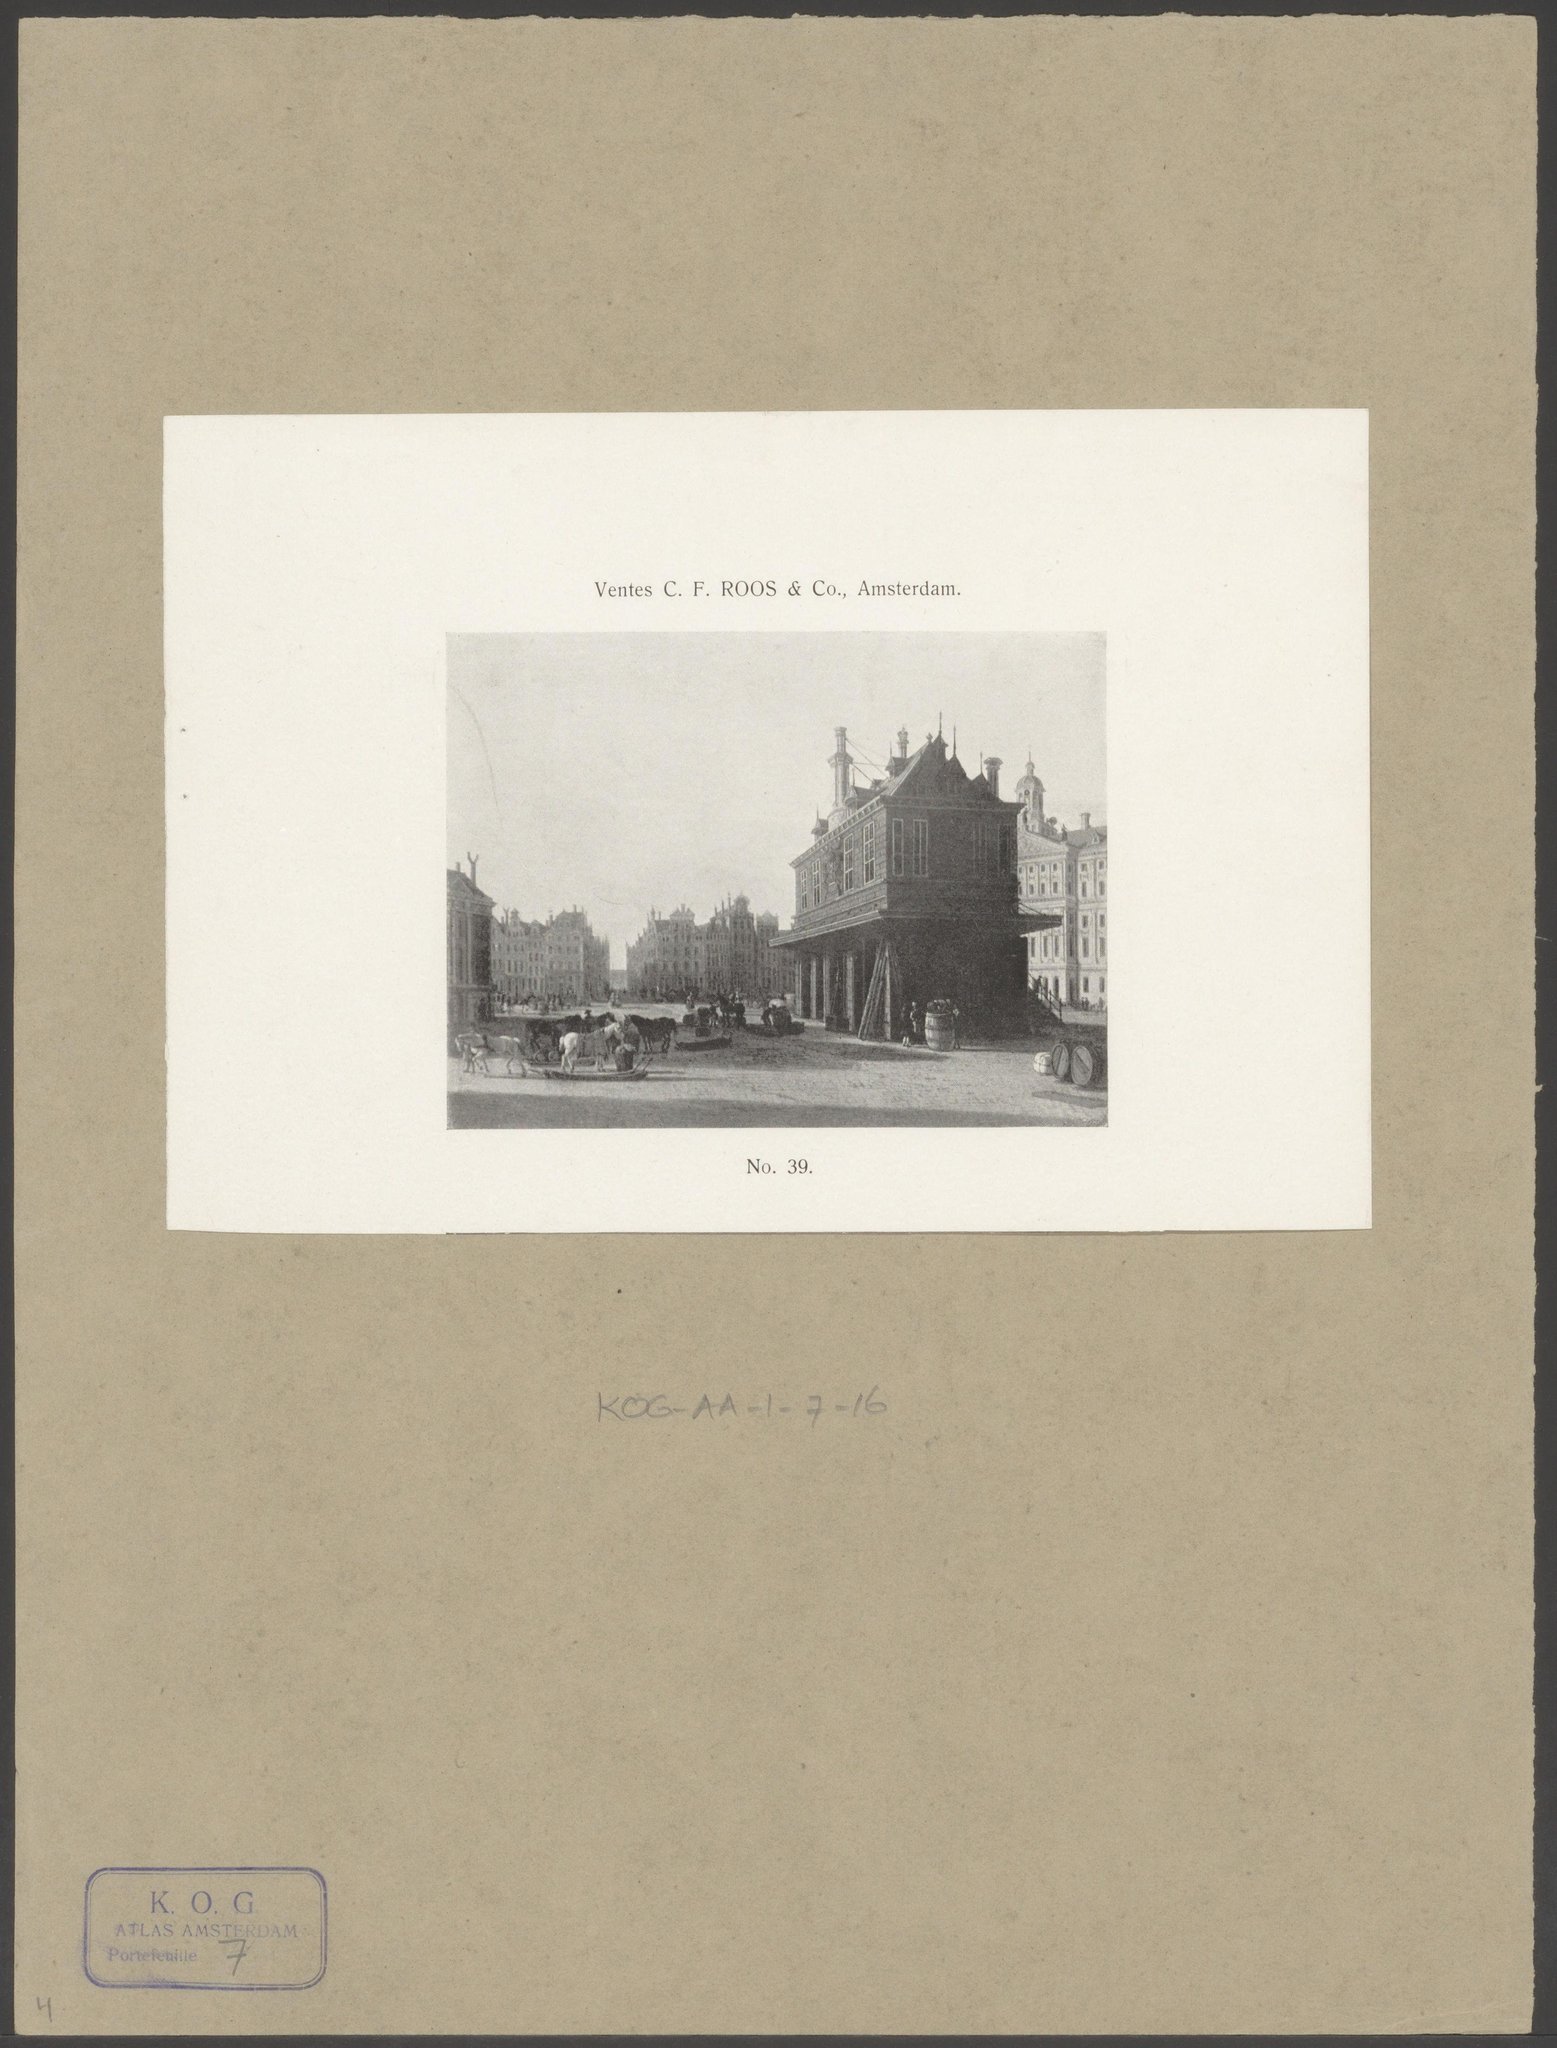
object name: photomechanical print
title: Gezicht op de Waag op de Dam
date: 1908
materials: paper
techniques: autotype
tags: square, place, circus, etc., city-view in general; 'veduta', townhall, weigh-house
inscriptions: collector's mark: ‘7’ Lugt 1641b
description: Onderwerpsrubriek binnen de Atlas Amsterdam: Dam (voor 1835).